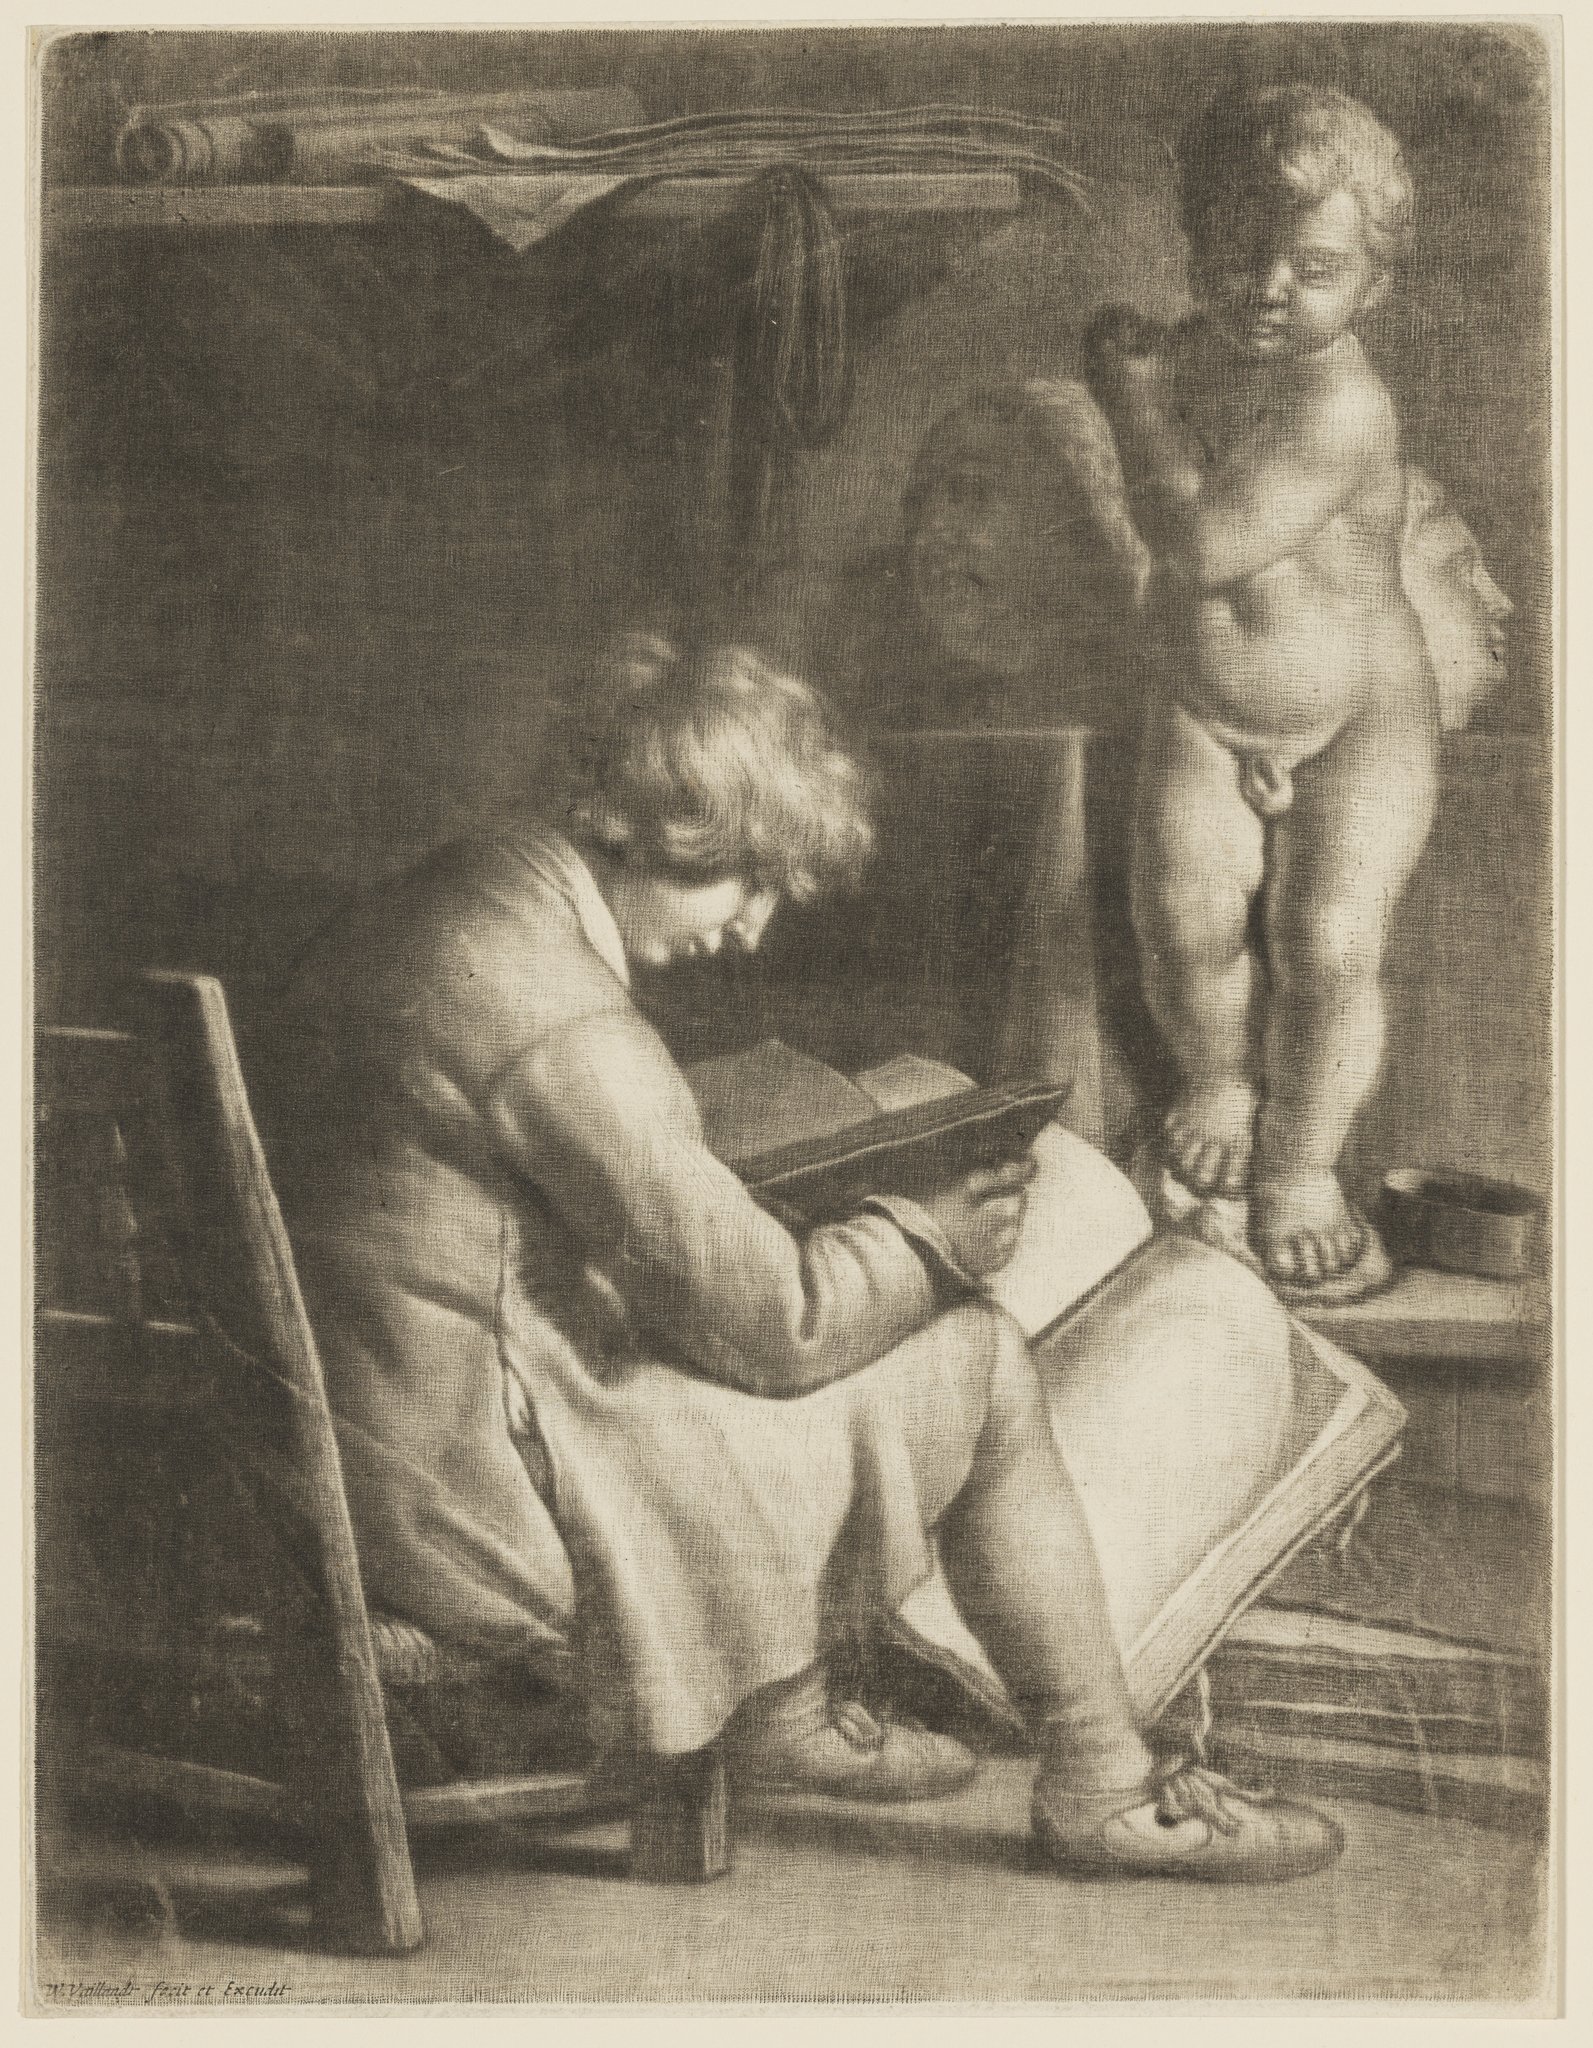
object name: print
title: Boy Seated in a Studio, a plaster cast of the Christ-child in front of him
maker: wallerant vaillant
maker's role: artist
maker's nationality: dutch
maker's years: 1623-1677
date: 1601-1700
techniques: mezzotint